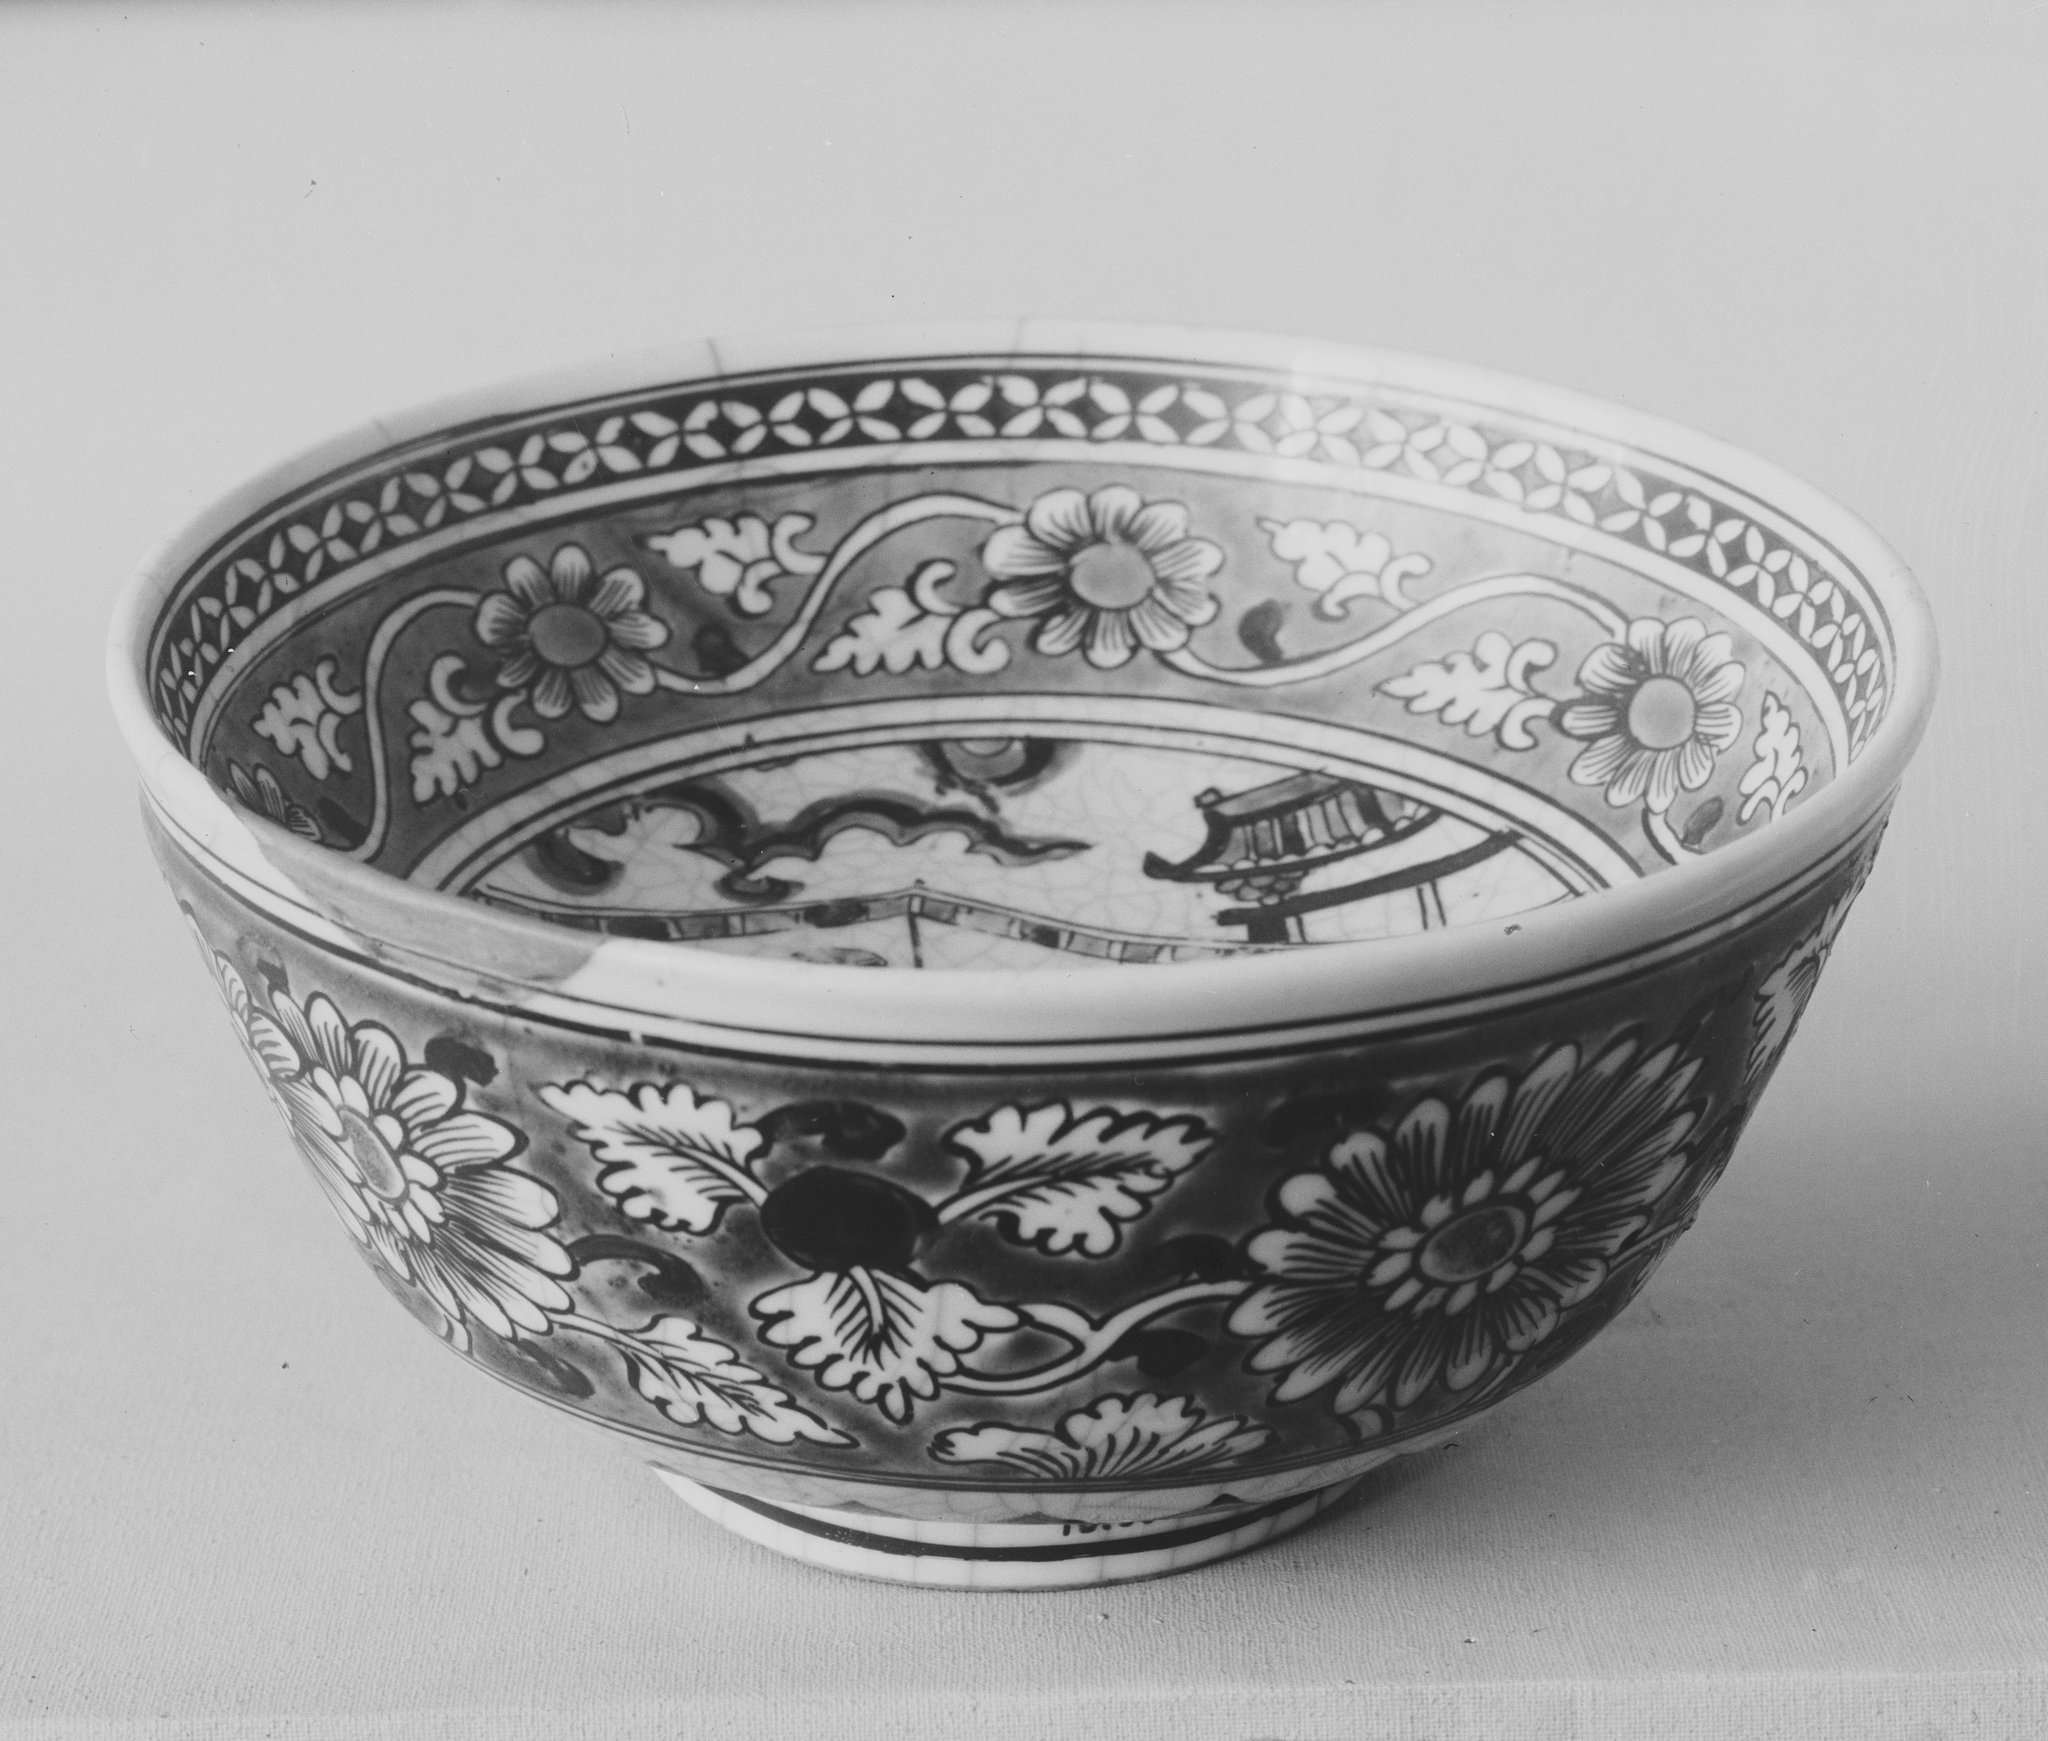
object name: bowl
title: Double-bottomed Bowl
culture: chinese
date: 1534-1566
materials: enamel, porcelain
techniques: overglaze, painting, polychrome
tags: flowers,leaves